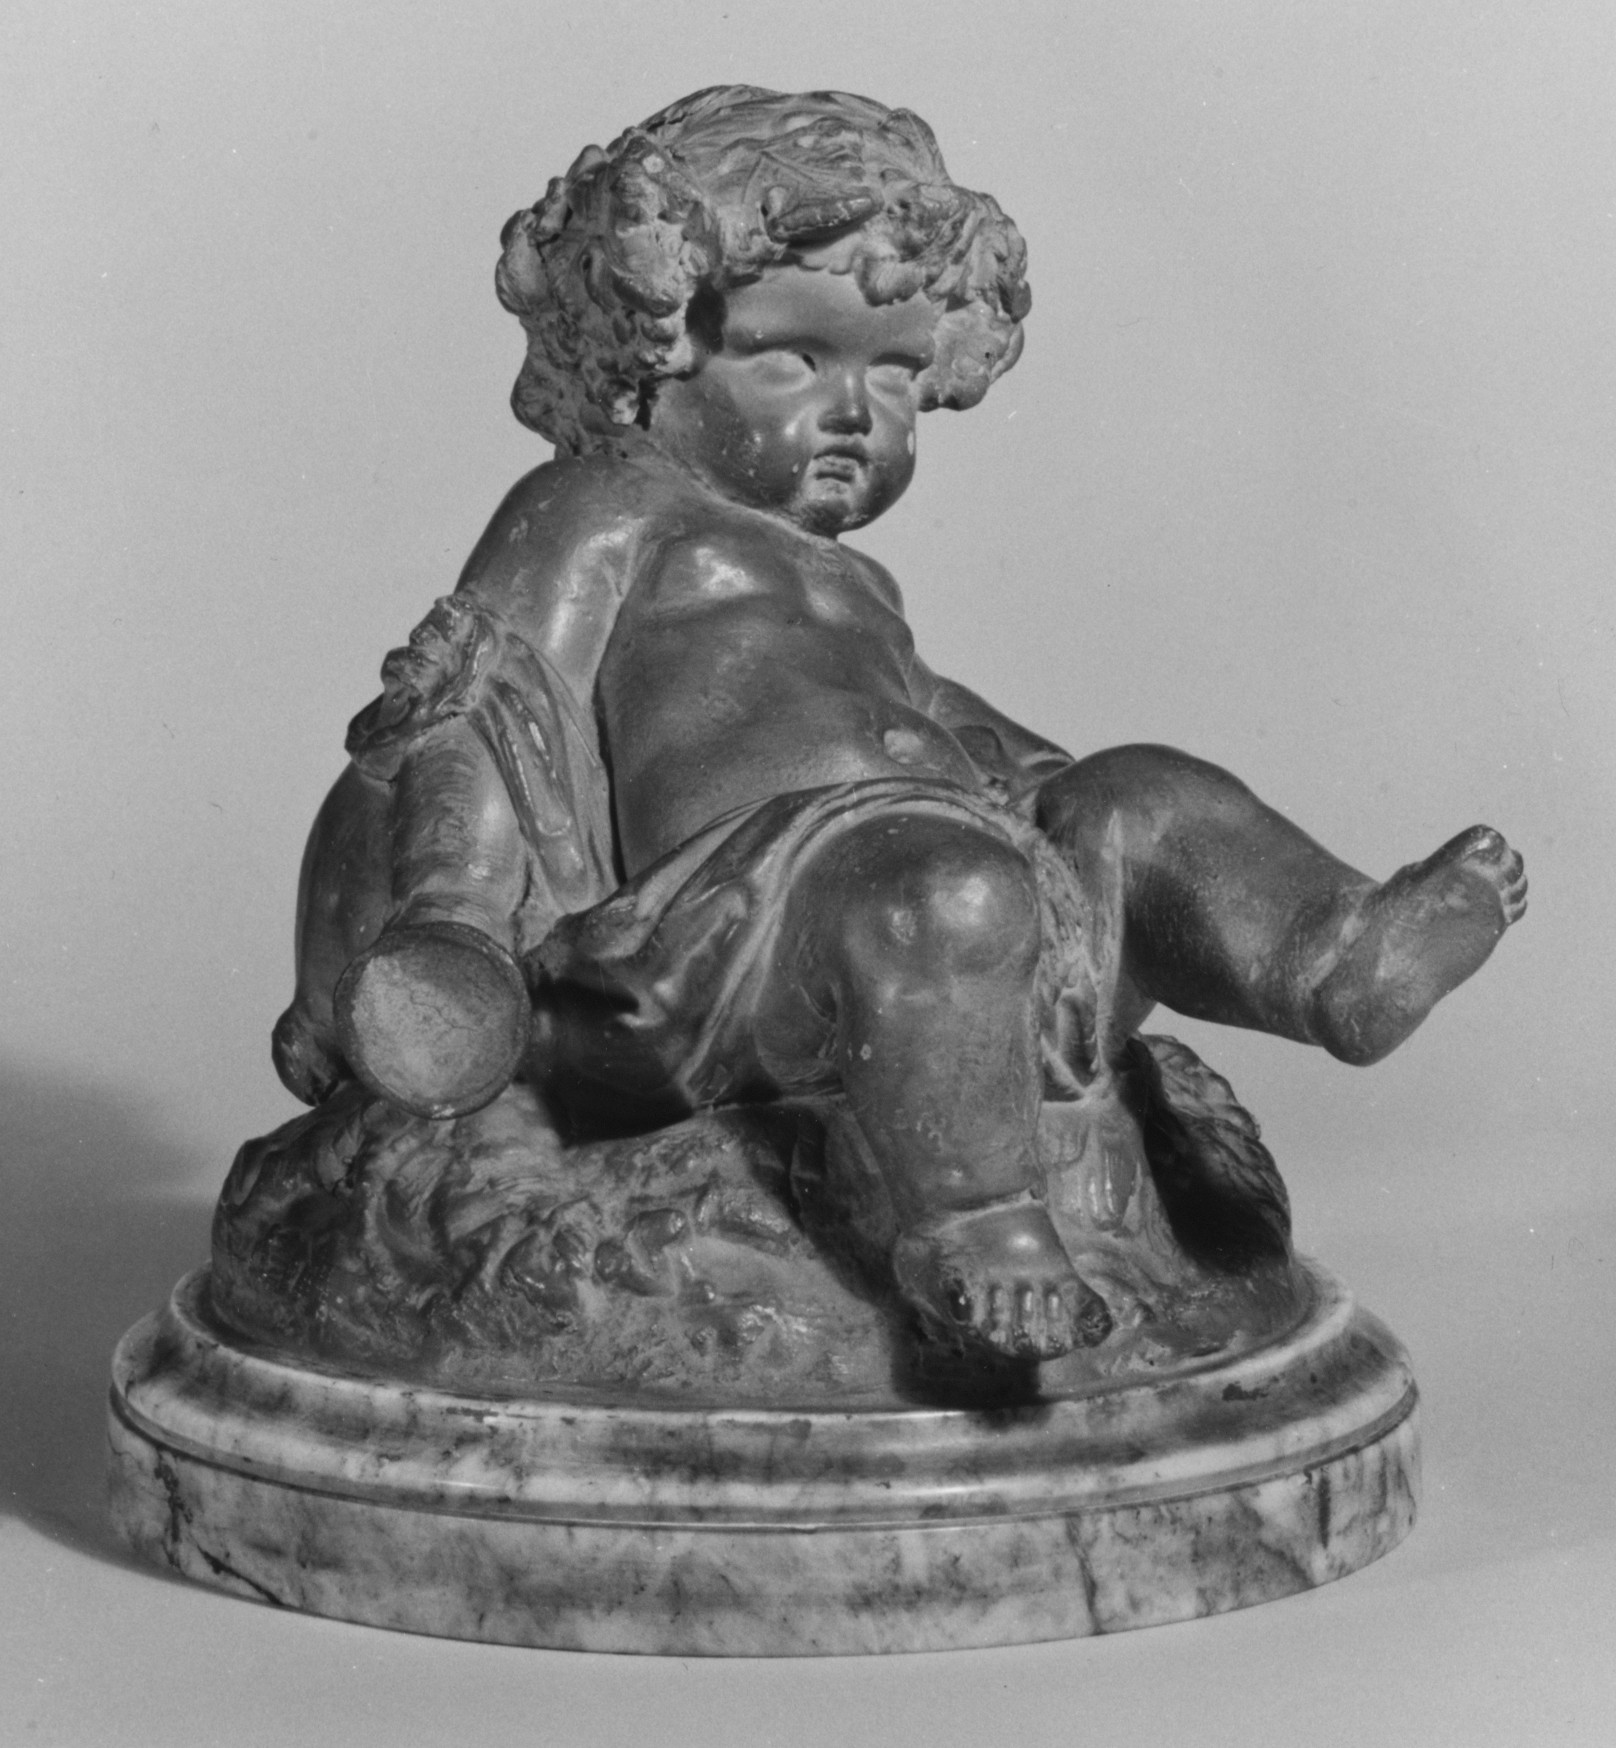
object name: statuette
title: Bacchic infant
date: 1767-1800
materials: marble, terracotta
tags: infants,bacchus